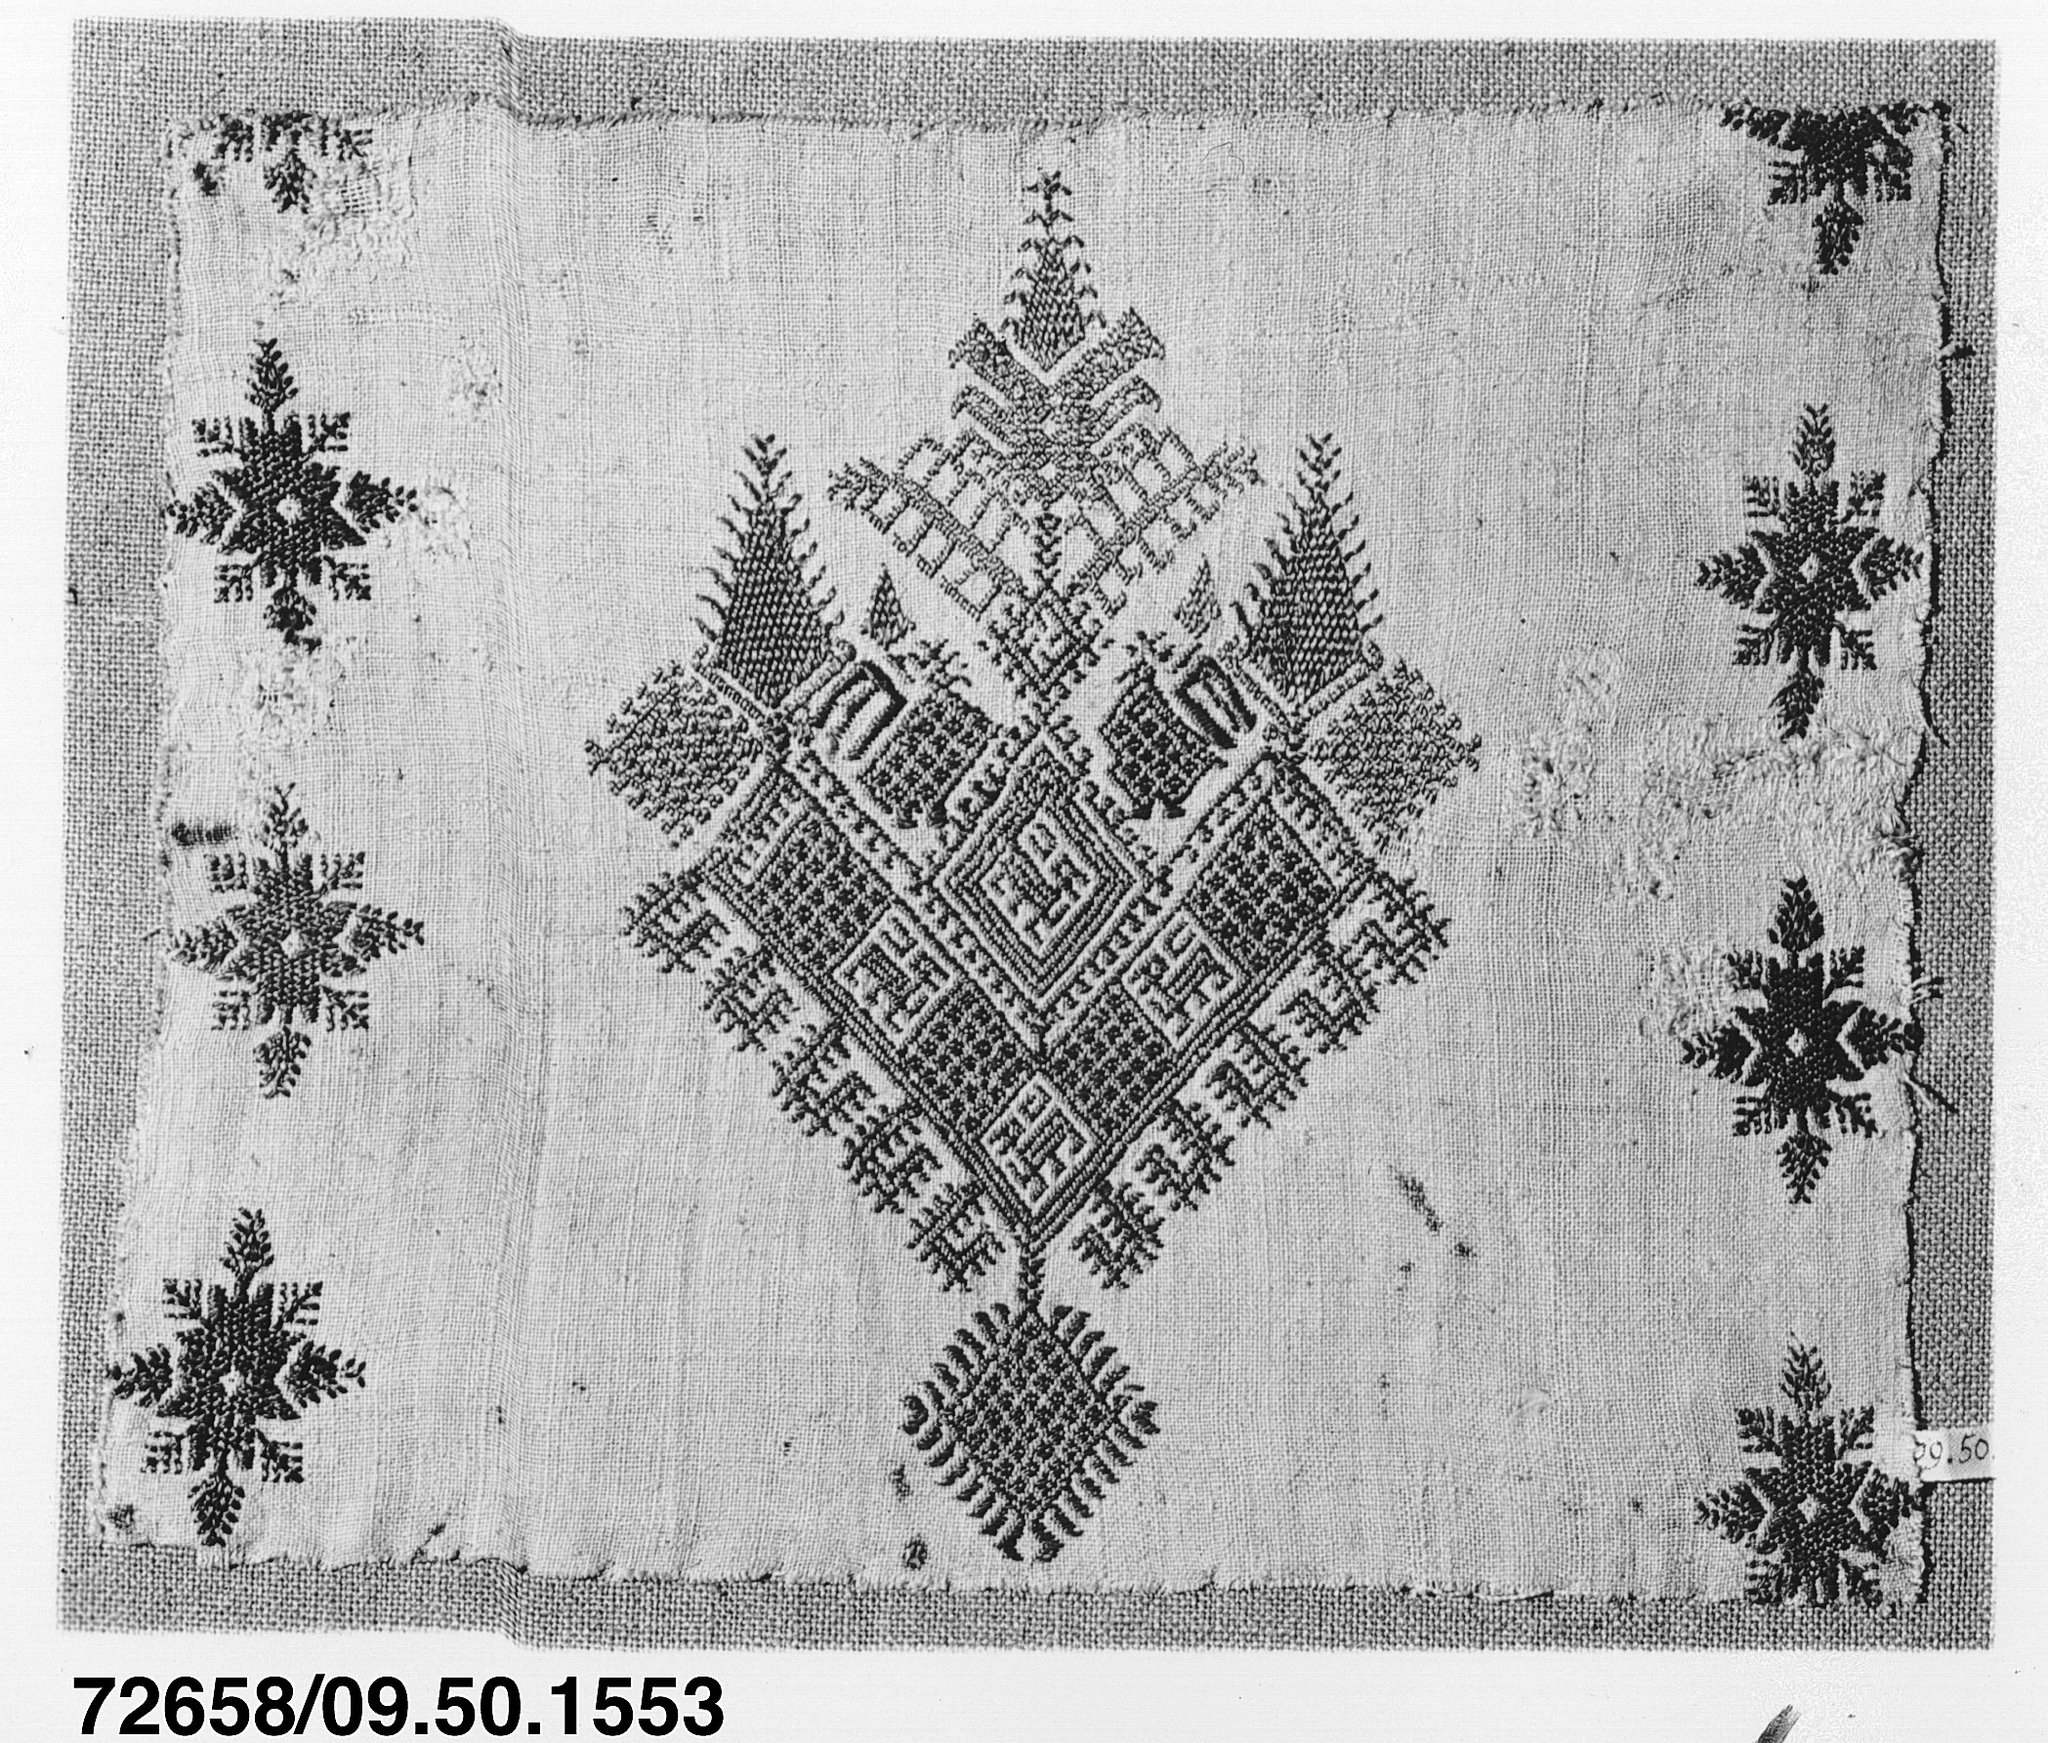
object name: bed curtain fragment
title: Bed curtain, fragment from a border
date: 1701-1800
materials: linen, silk